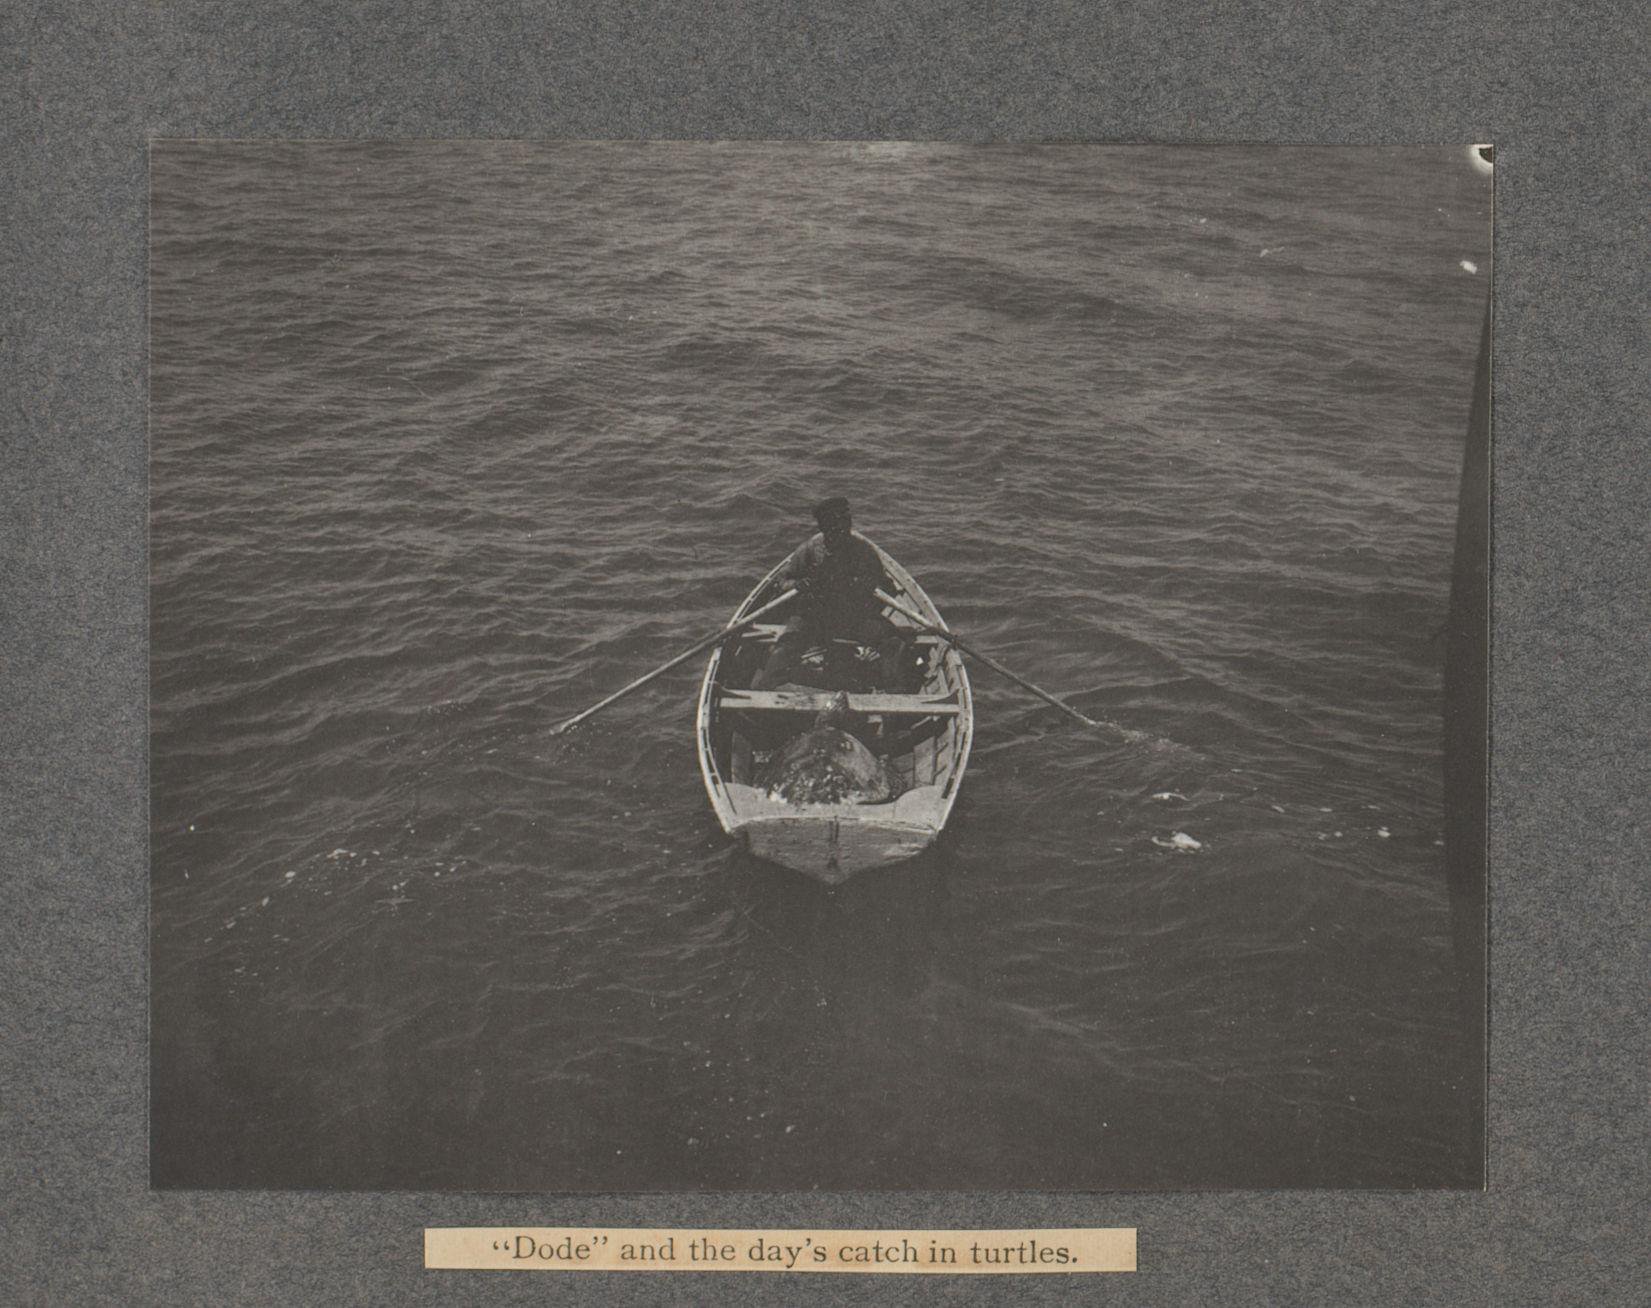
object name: album leaf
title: Man in roeiboot met een gevangen zeeschildpad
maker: Anonymous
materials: paper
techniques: platinum process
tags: tortoises, turtles, rowing-boat, canoe, etc., fishing (sports)